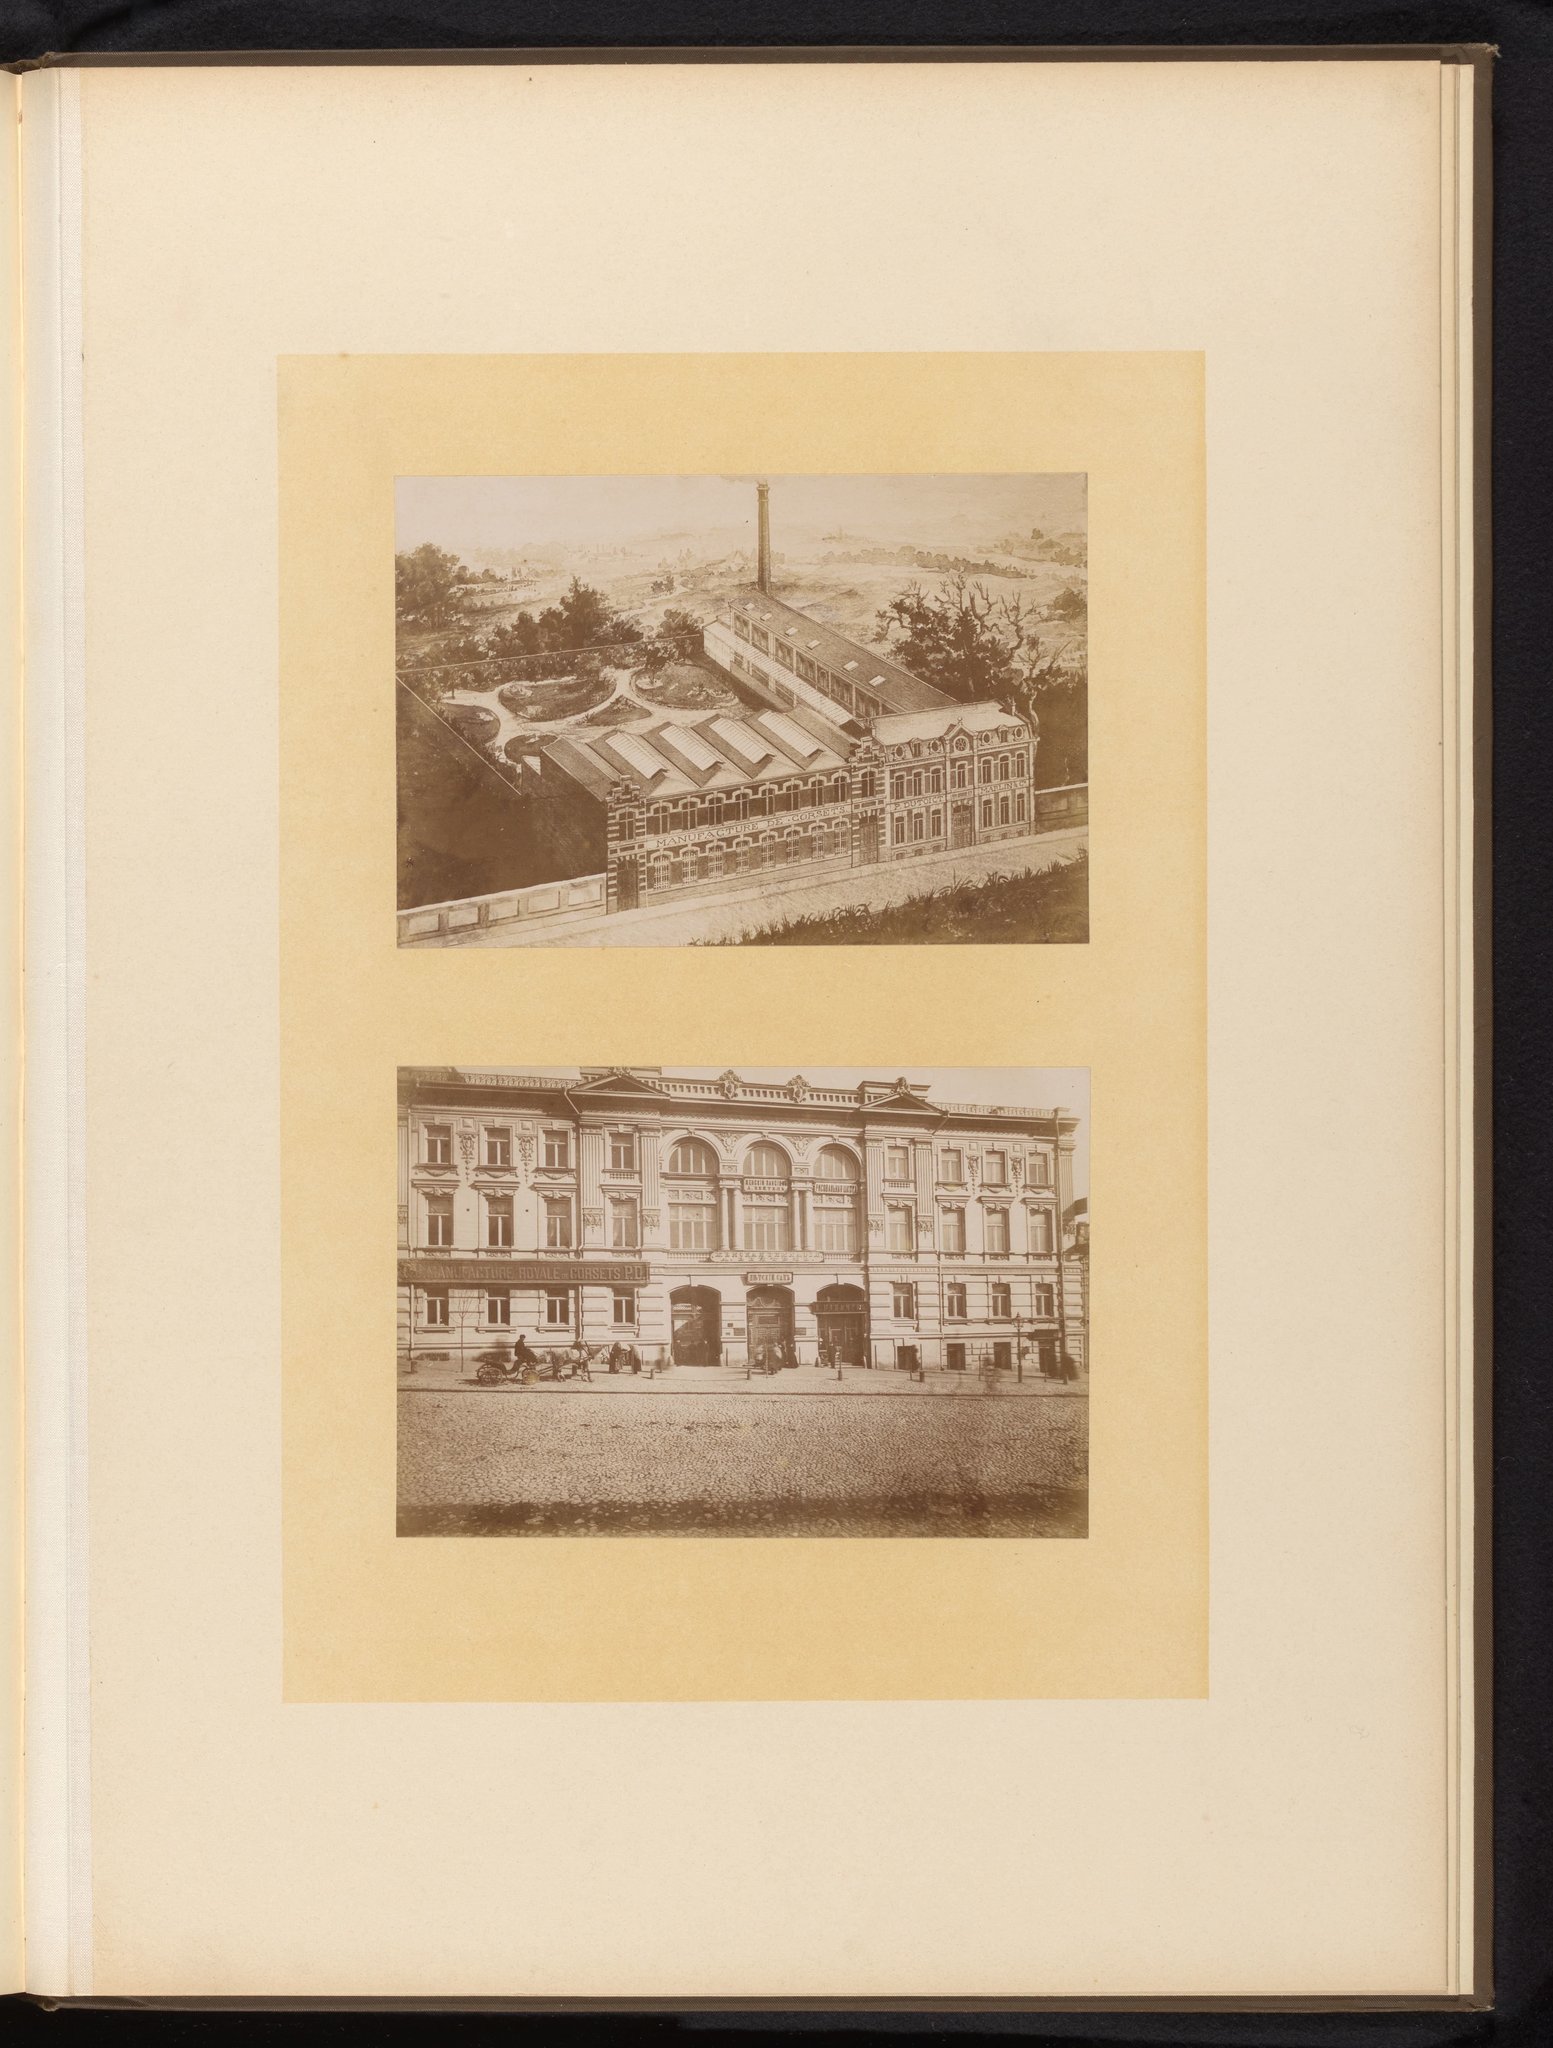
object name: page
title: Fotoreproductie van een gezicht op een corsetfabriek en een façade van een corsetfabriek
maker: Anonymous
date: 1890-1895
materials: photographic support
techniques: collodion silver print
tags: factory-building, factory in landscape (+ city(-scape) with figures, staffage)